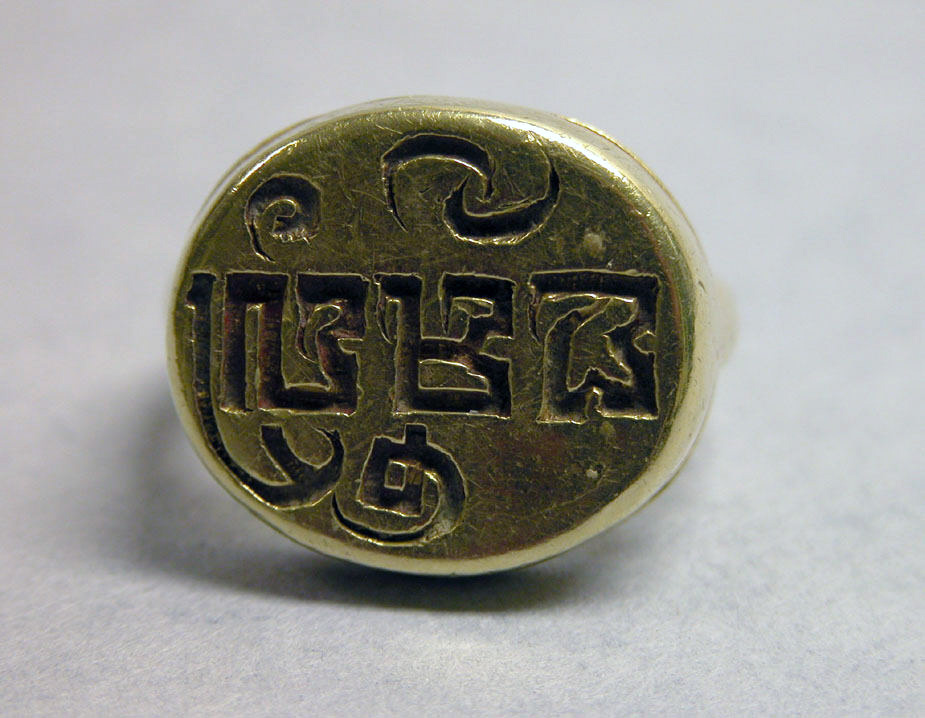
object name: ring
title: Ring with Plain Oval Bezel and "Jawa Kuno" Inscription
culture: indonesian, javanese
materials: gold